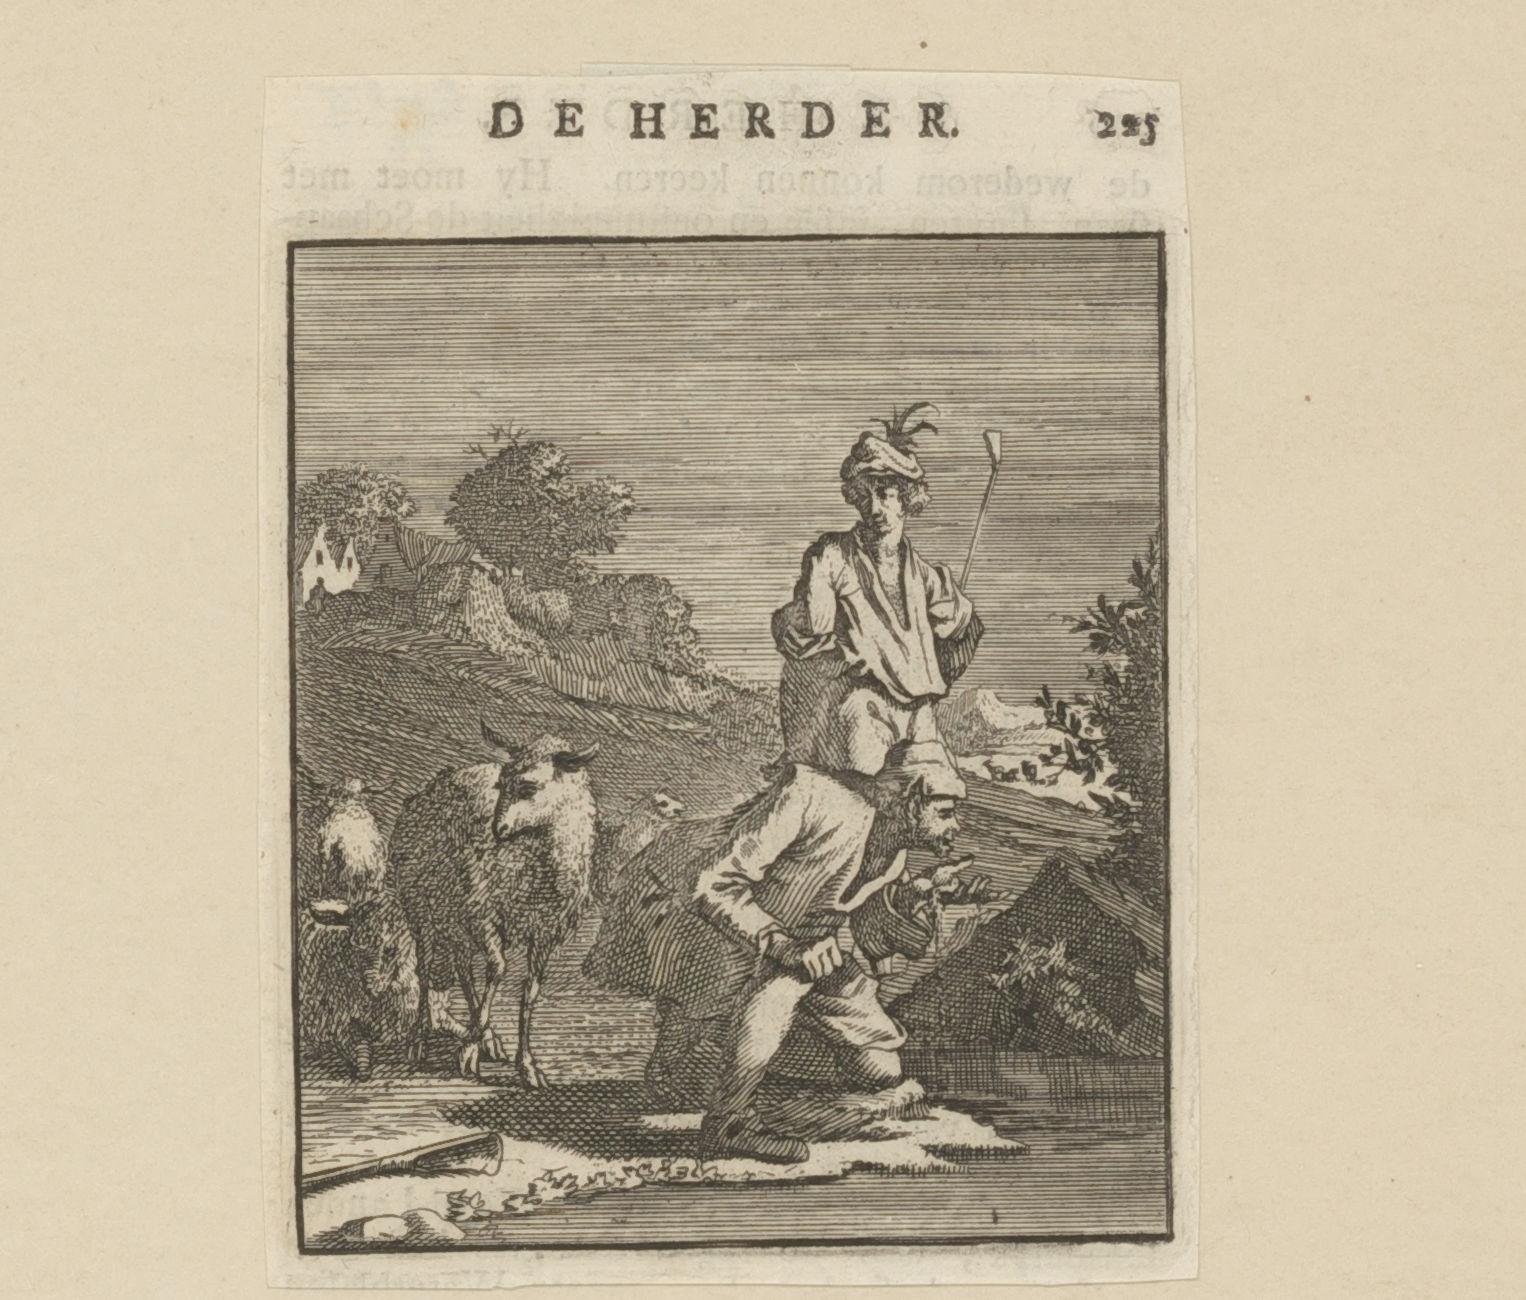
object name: print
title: Twee herders in de bergen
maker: Anonymous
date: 1719-1759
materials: paper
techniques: etching, letterpress printing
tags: herding, herdsman, herdswoman, shepherd, shepherdess, cowherd, etc., herd, flock, mountains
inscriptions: stamp, collector's mark: Lugt 1641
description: Prent met andere letterzetting gebruikt in: St. Clara, Abraham van. Iets voor allen. [Vertaald door] J. le Long. Amsterdam: Janssoons van Waesberge, 1719, dl. 2. En in: St. Clara, Abraham van. Iets voor allen. [Vertaald door] J. le Long. Amsterdam: Jan Roman de Jonge, 1741, dl. 2. En in: St. Clara, Abraham van. Iets voor allen. [Vertaald door] J. le Long. Amsterdam: Jan Roman, 1759, dl. 2. Huidige prent uit een andere editie. Naar een prent van: Jan Luyken.